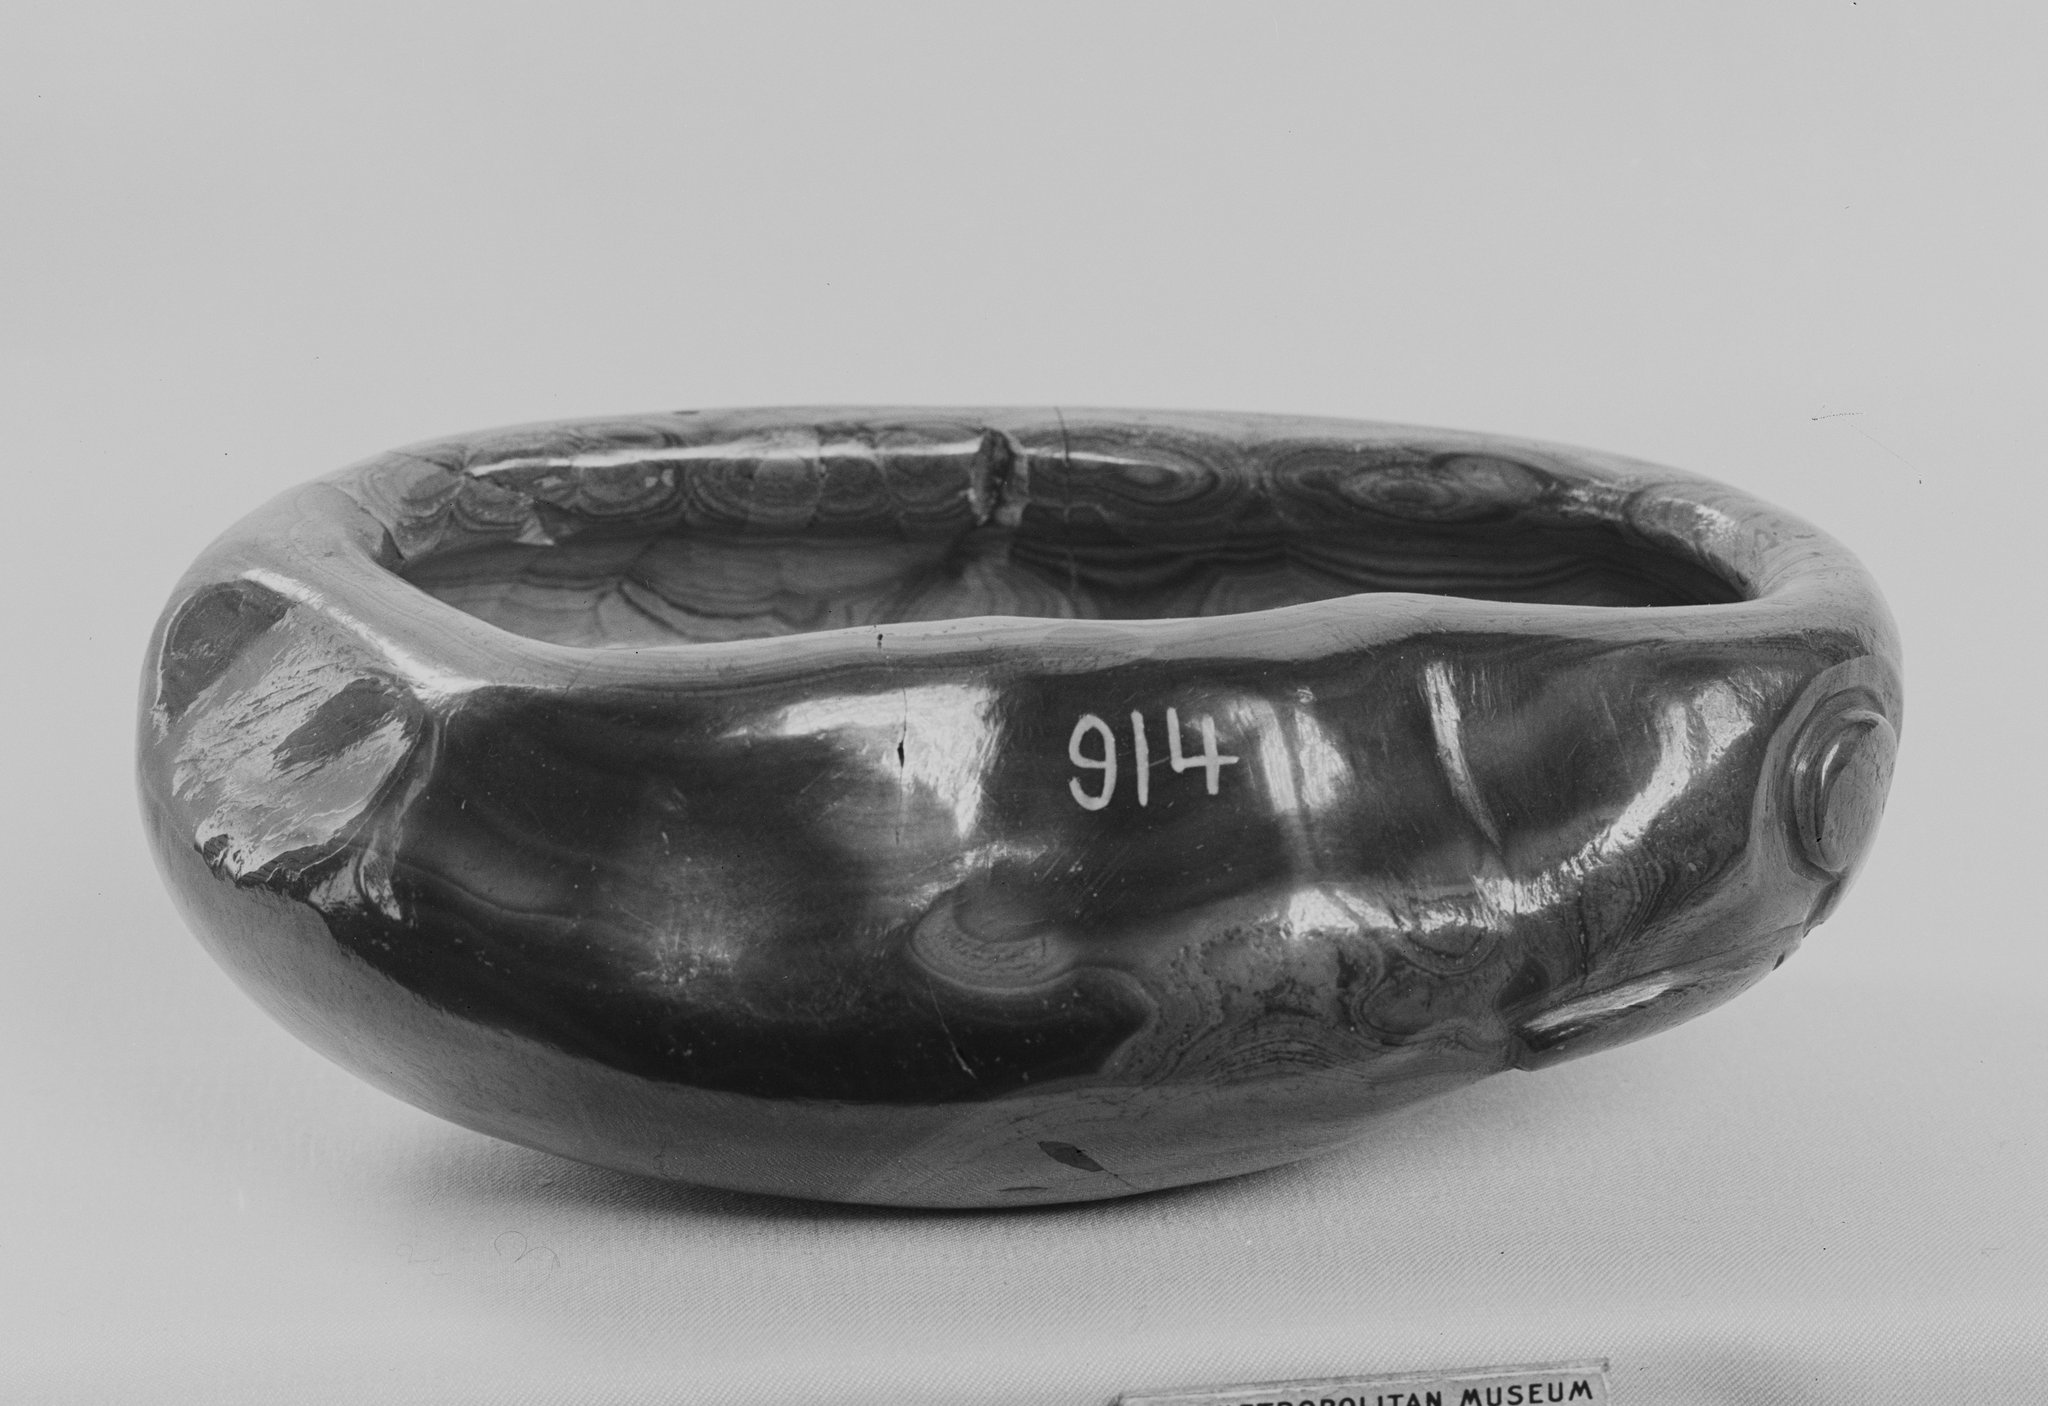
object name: brush washer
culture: chinese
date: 1701-1800